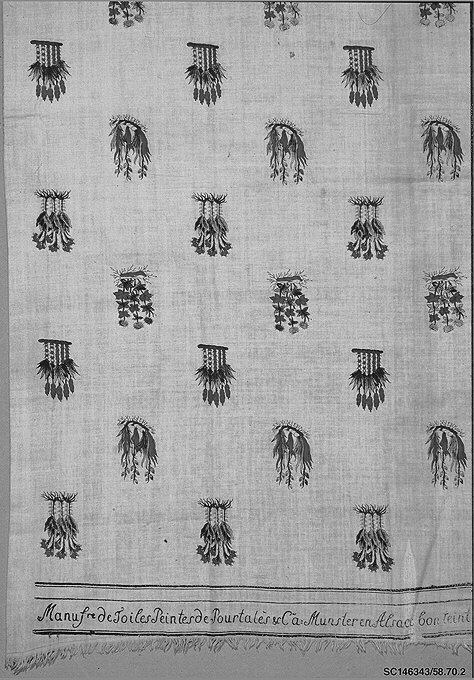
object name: piece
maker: pourtalès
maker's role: manufactory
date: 1767-1800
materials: cotton